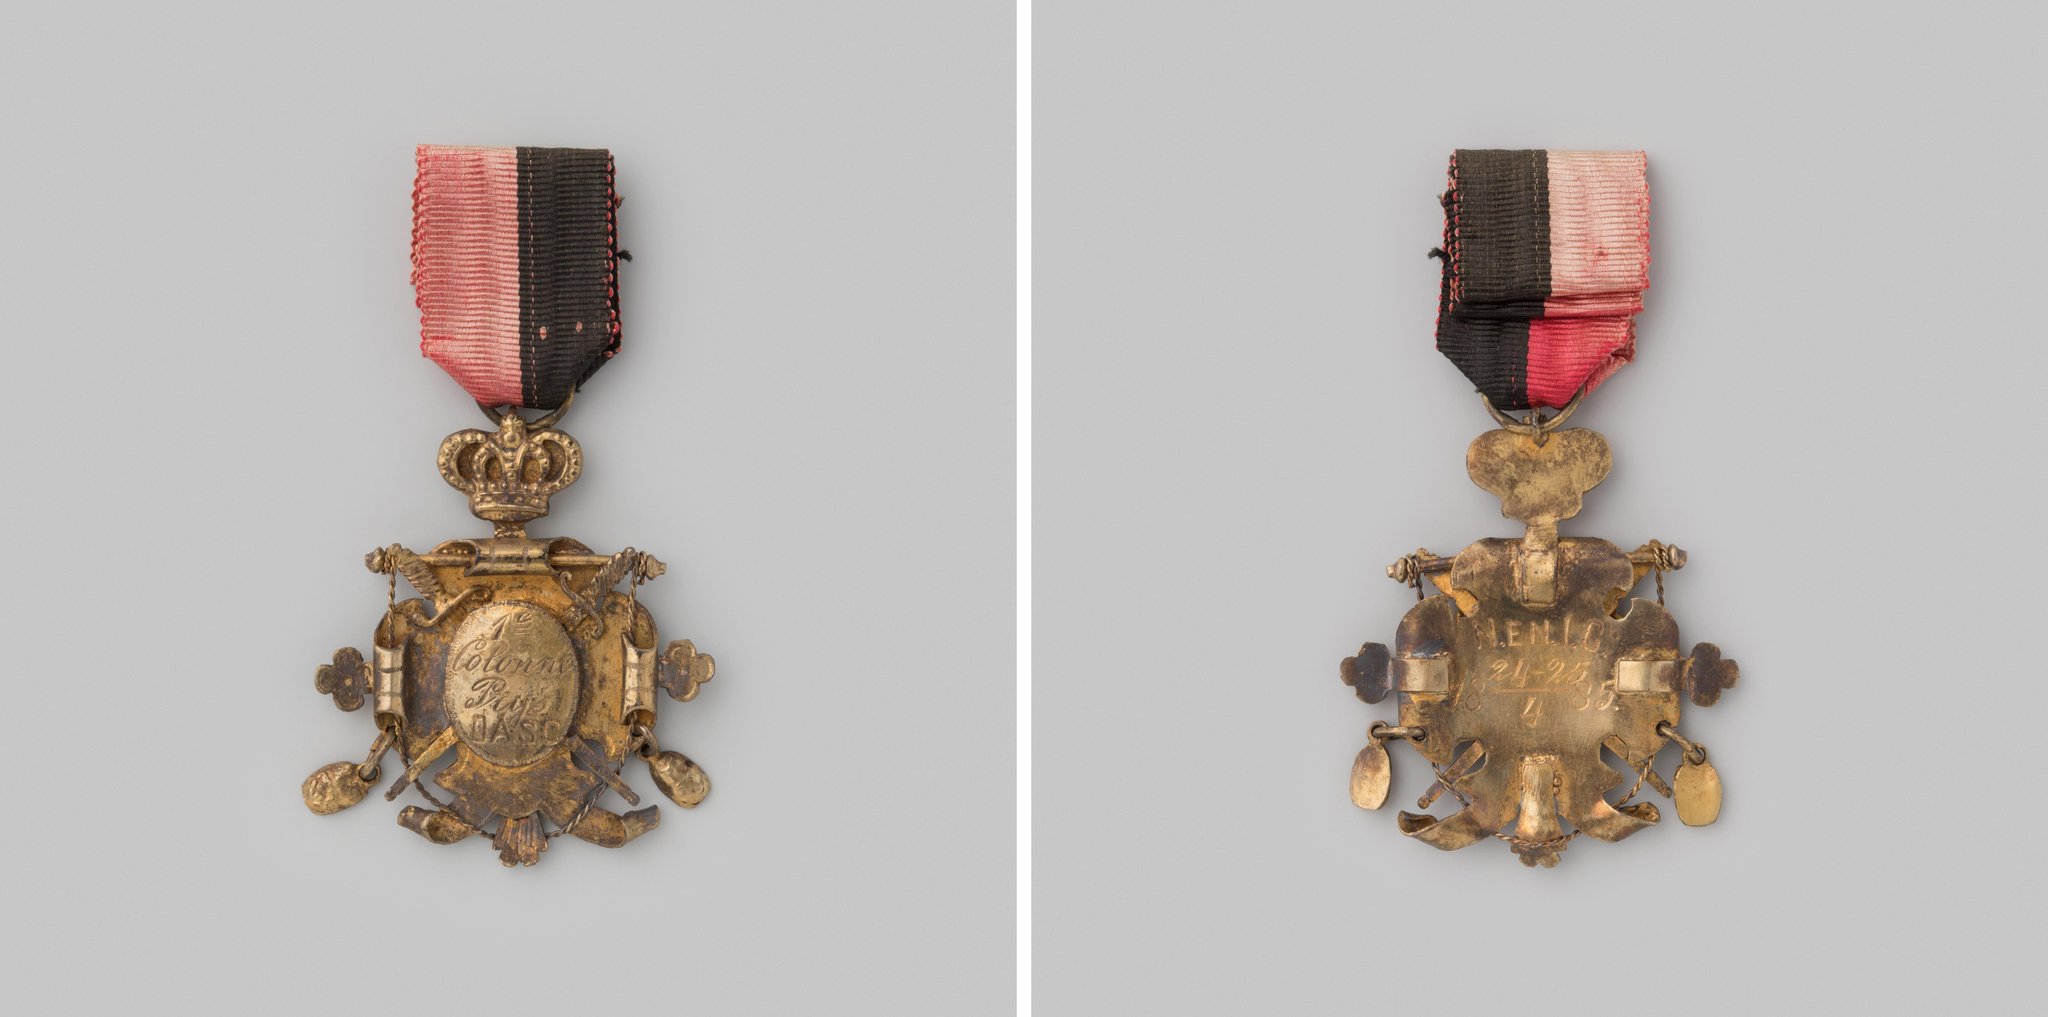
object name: medal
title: Prijspenning nationaal en internationaal concours van de onderlinge Amsterdamse schermcursus, behaald door de vereniging van onderofficieren van de schutterij te Amsterdam, eerste Colonneprijs voor schermen op de degen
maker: Anonymous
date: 1885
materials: silver, textile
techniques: gilding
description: Verguld zilveren penning gedekt door koningskroon met oog, ring en lint.